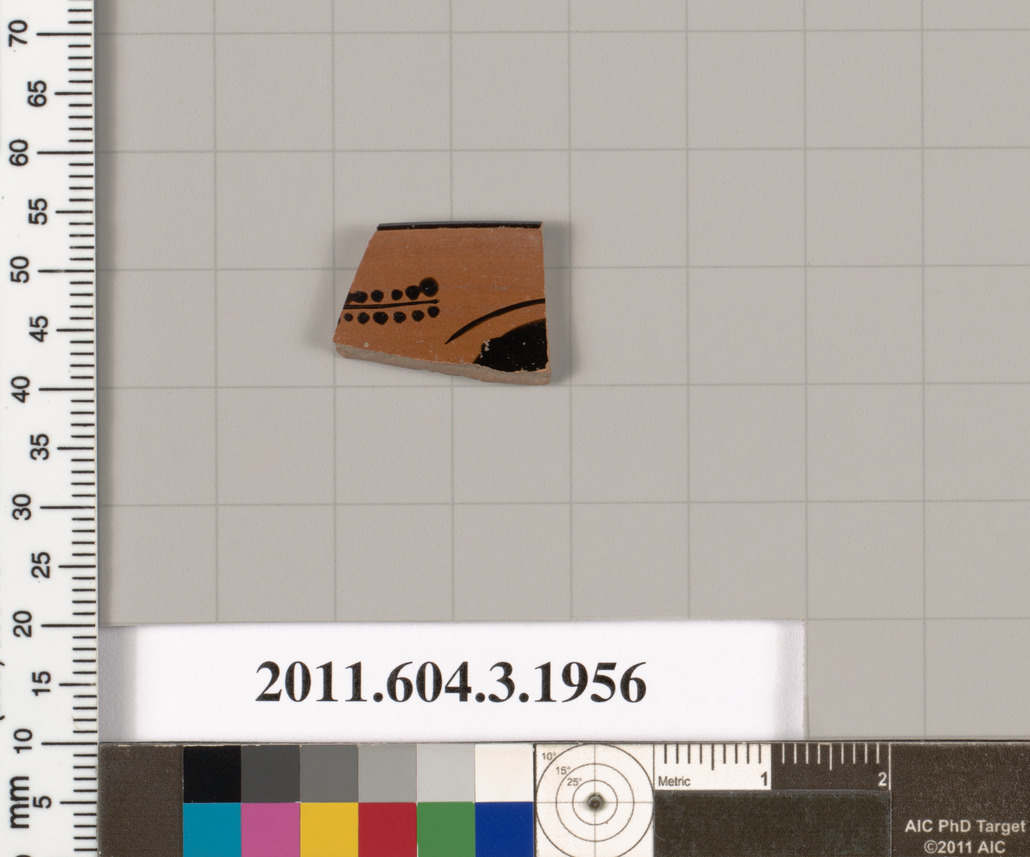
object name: kyathos fragment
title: Terracotta fragment of a kyathos (cup-shaped ladle)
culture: greek, attic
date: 534-468 BCE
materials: terracotta